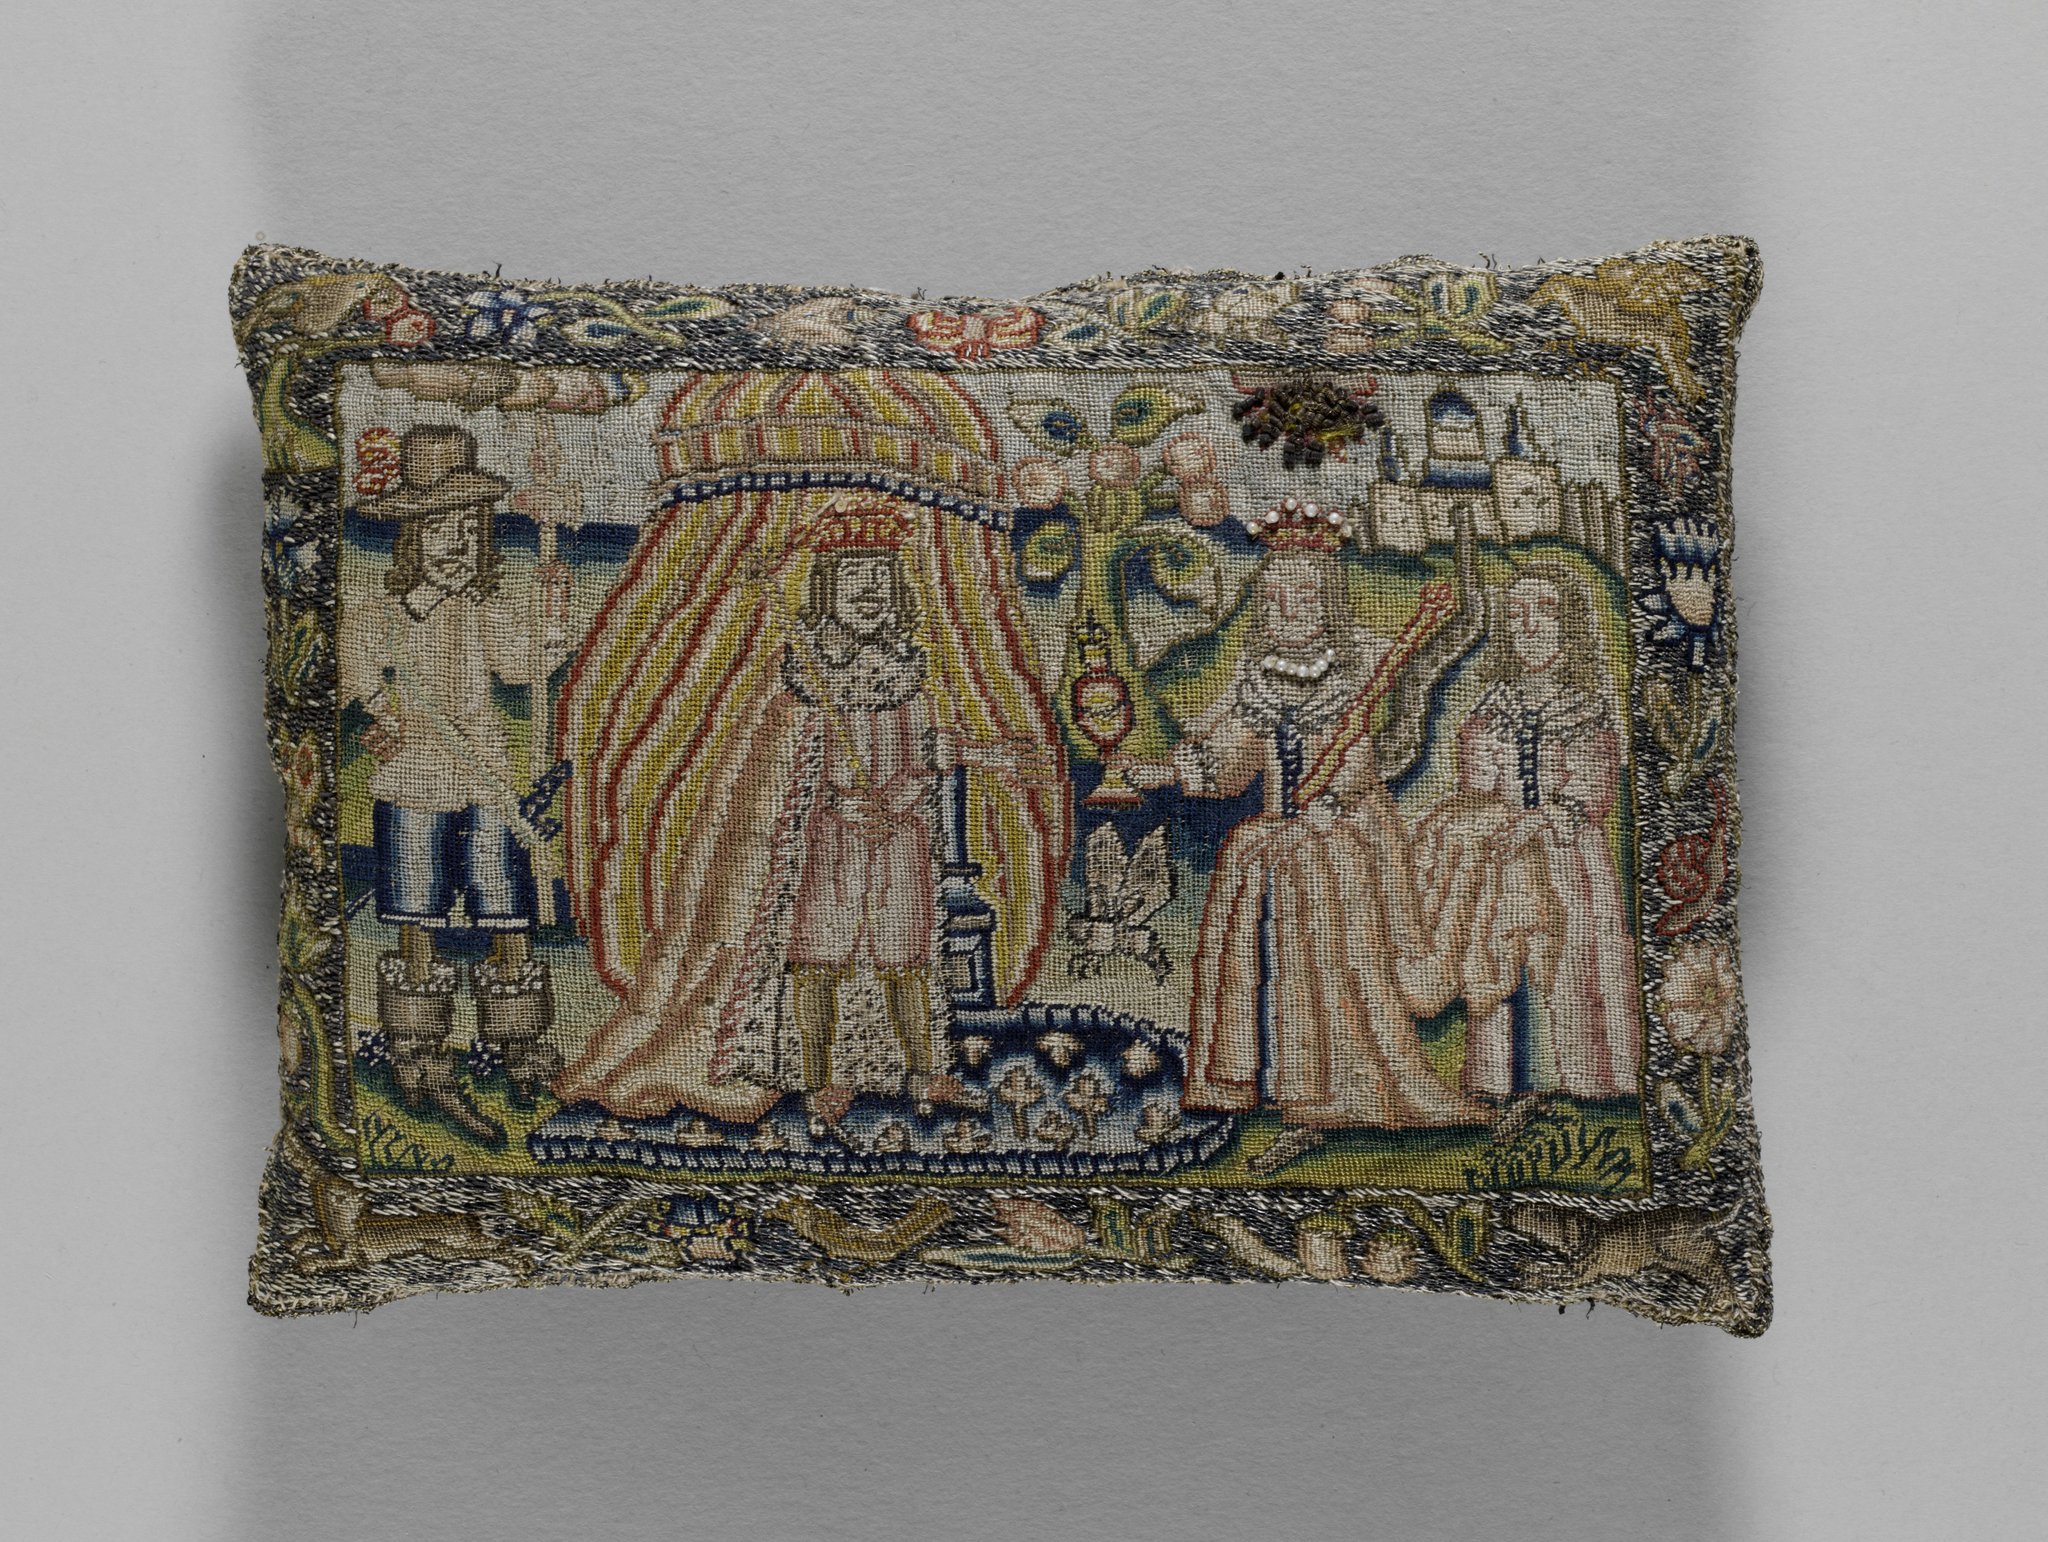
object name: cushion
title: Cushion with Solomon and Sheba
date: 1634-1666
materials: canvas, metal thread, pearl, silk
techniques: embroidery, stitching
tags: kings,queens,men,women,insects